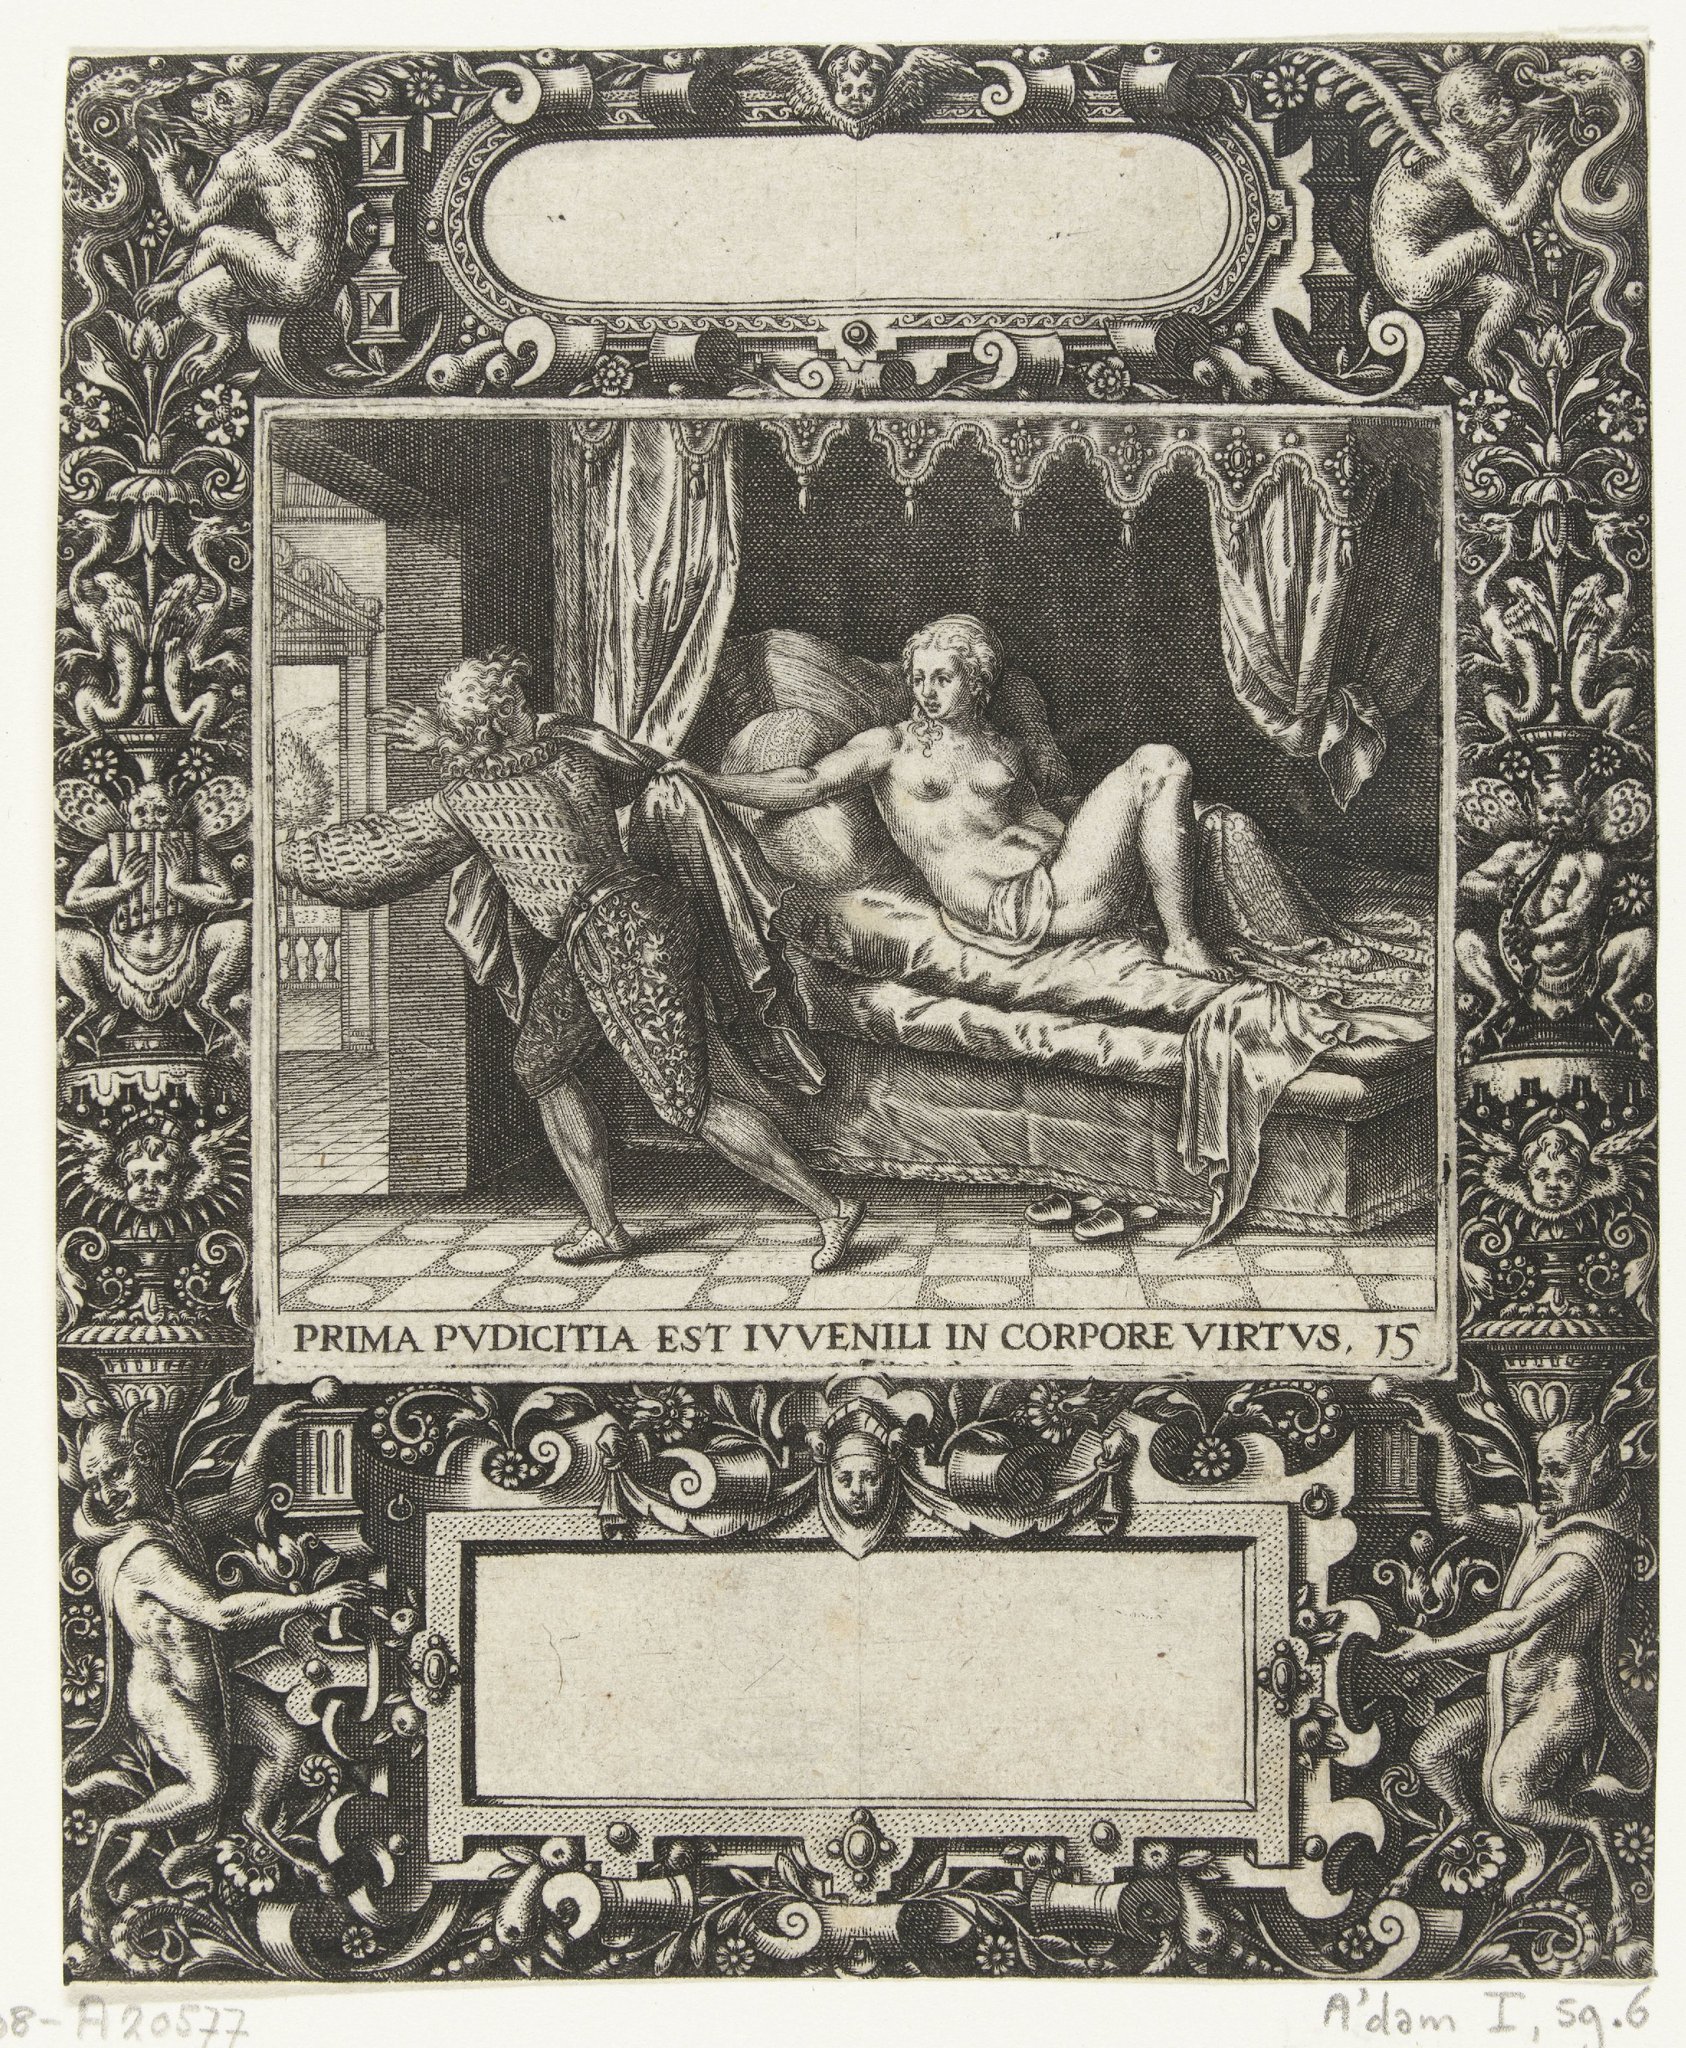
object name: print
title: Omlijsting met een langwerpige cartouche met ronde zijkanten middenboven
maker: theodor de bry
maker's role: draughtsman, print maker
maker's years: 1528-1598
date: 1593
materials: paper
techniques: engraving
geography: netherlands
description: Rechthoekige cartouche middenonder. Linksboven en rechtsboven zit een gevleugelde aap. Emblemata met nummer 15. Hoort bij een serie van 18 bladen waarbij in het midden van aparte platen zevenentwintig emblemata en vijfenveertig wapenschilden zijn gedrukt. De emblemata zijn ten dele genummerd A-D, 1-7 en 9-21. Drie bladen hebben geen nummer. De wapenschilden, die deels dubbel zijn afgedrukt, zijn ongenummerd.